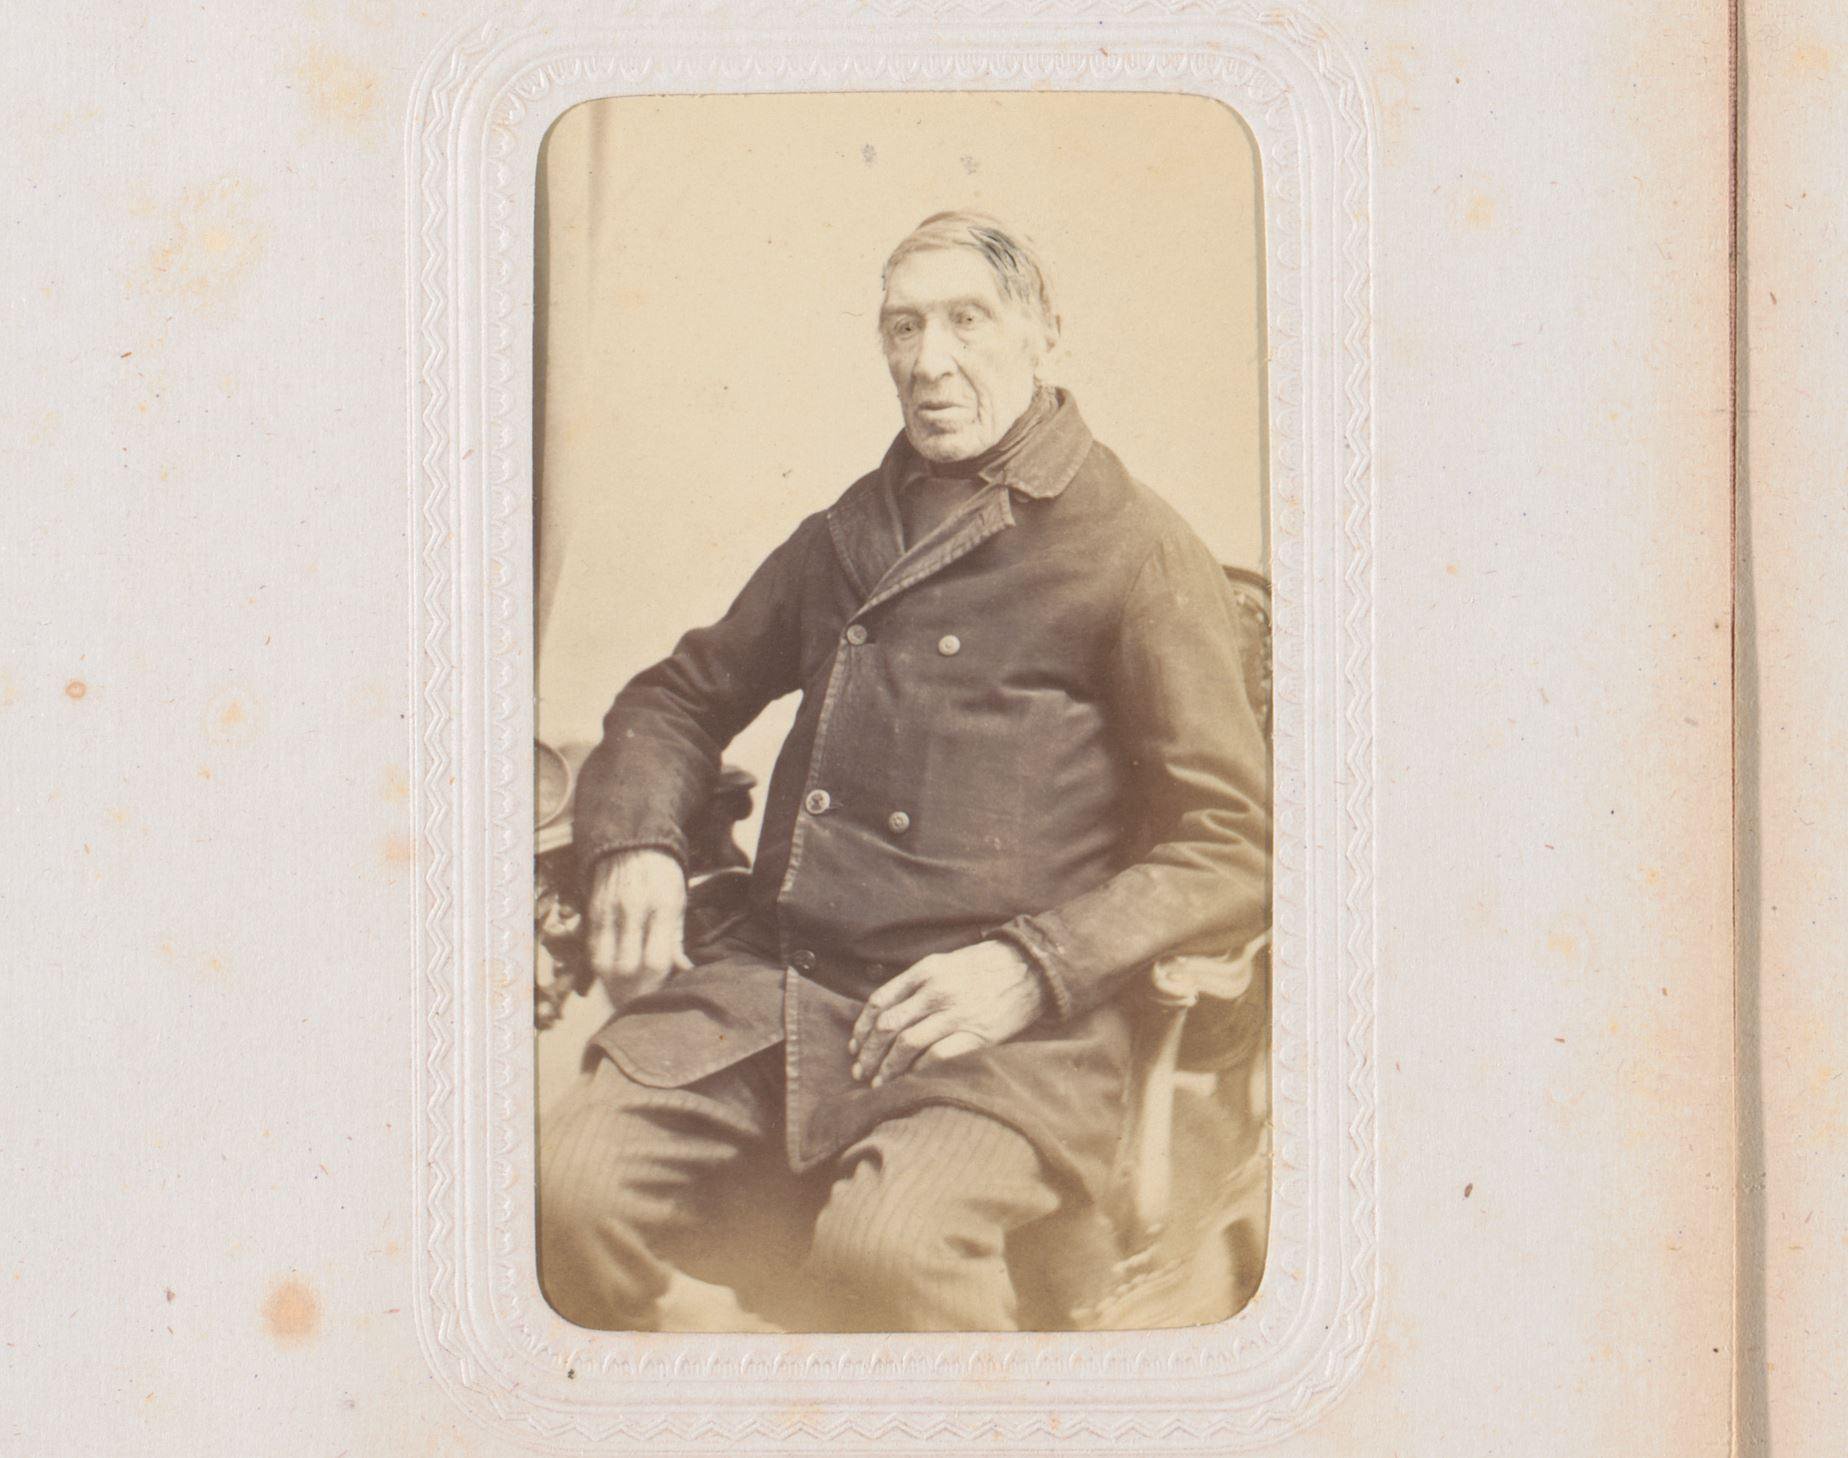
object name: album leaf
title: Portret van een zittende man, aangeduid als Jan Kooimans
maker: kornelis willem schorteldoek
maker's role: boekbinder, fotograaf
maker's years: 1800-1885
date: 1855-1885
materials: cardboard, photographic support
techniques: albumen print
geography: gorinchem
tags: sitting figure, historical persons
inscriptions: inscription: ‘SCHORTELDOEK/ PHOTOGRAAF/ GORINCHEM/ Groote Markt’, name: ‘Jan Kooimans’